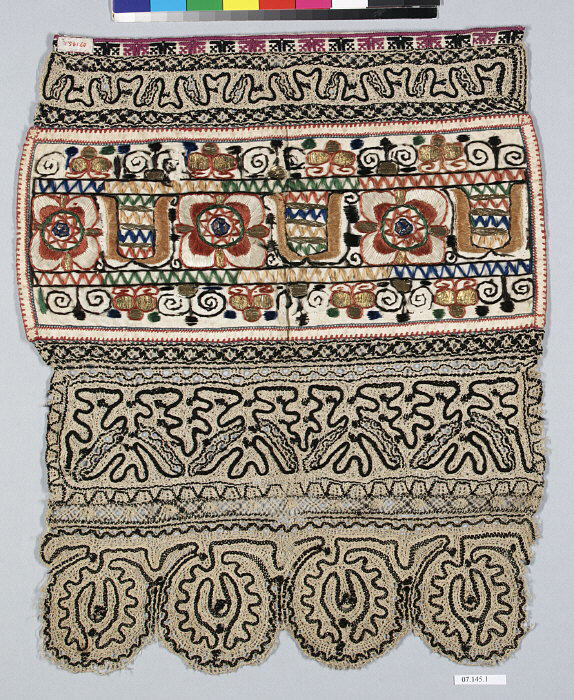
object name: cuff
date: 1801-1900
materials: thread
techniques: lace